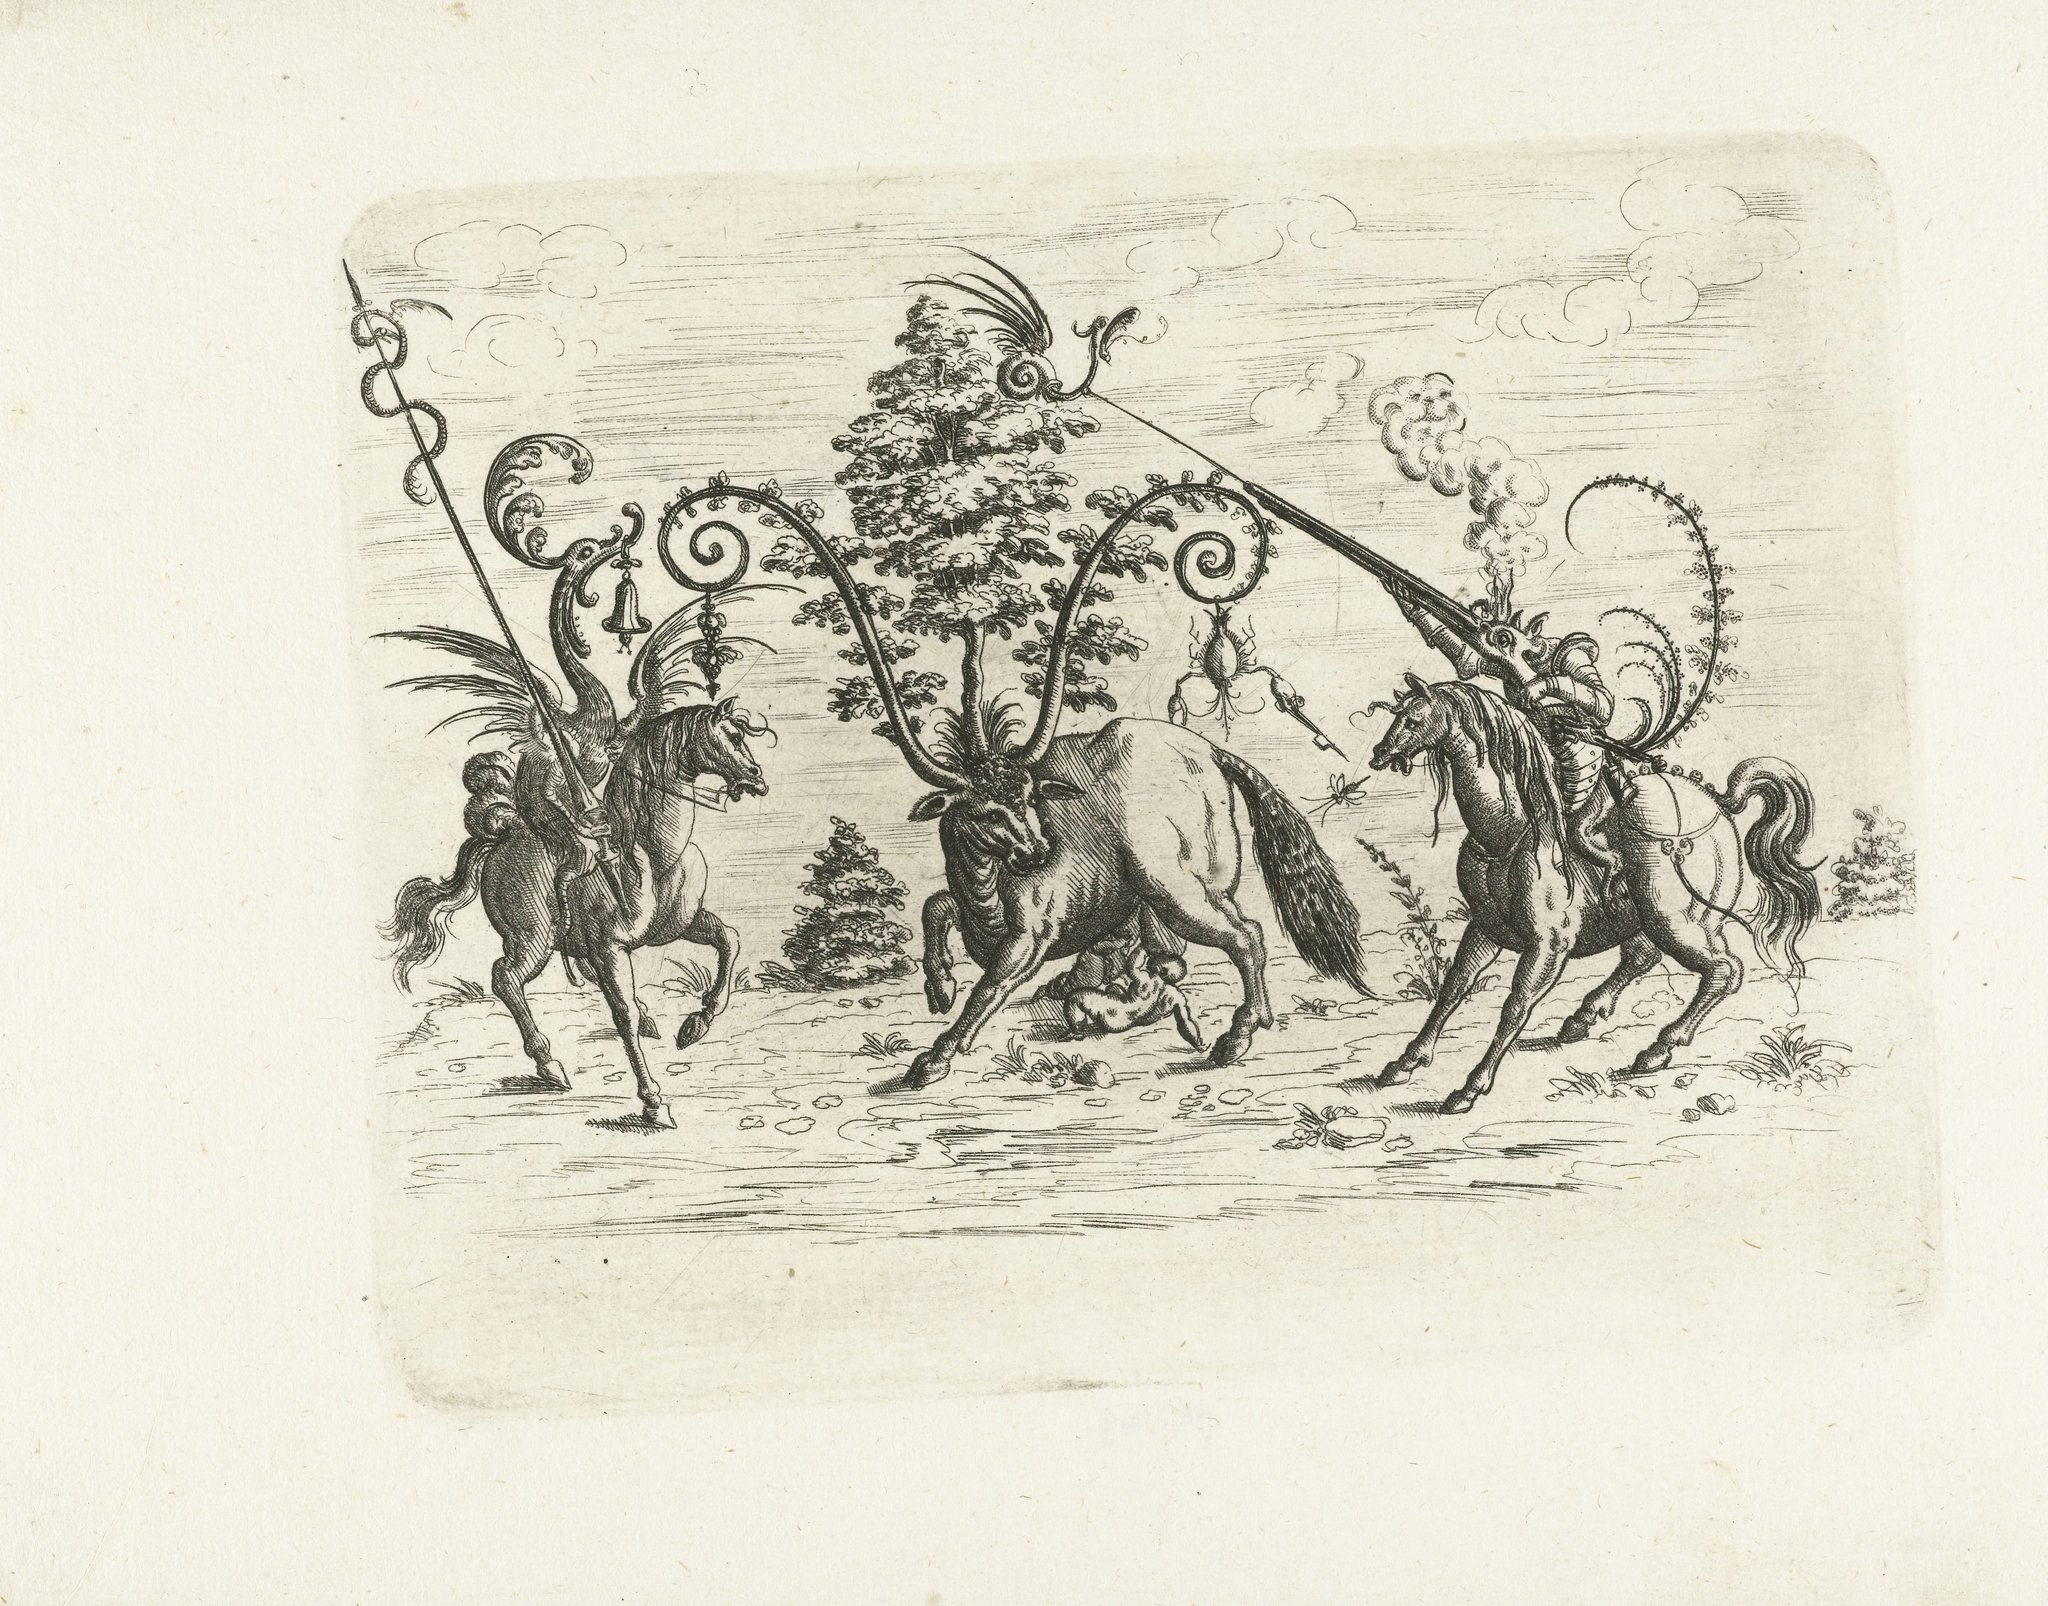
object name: ornament print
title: Das Neuw Grottesken Buch Nürnberg 1610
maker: christoph jamnitzer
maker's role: draughtsman, goldsmith, print maker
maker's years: 1563-1618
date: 1573-1610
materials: paper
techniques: etching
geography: germany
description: De koe draagt tussen de hoorns een grote boom. Twee kinderen zuigen aan haar uiers. Blad uit een serie vlakdecoraties met grotesken, cartouches, ovalen, mascarons, putti en fantastische wezens. De serie bestaat uit drie titelbladen, twee tekstbladen met de opdracht en het voorwoord en 60 bladen, verdeeld over drie boeken